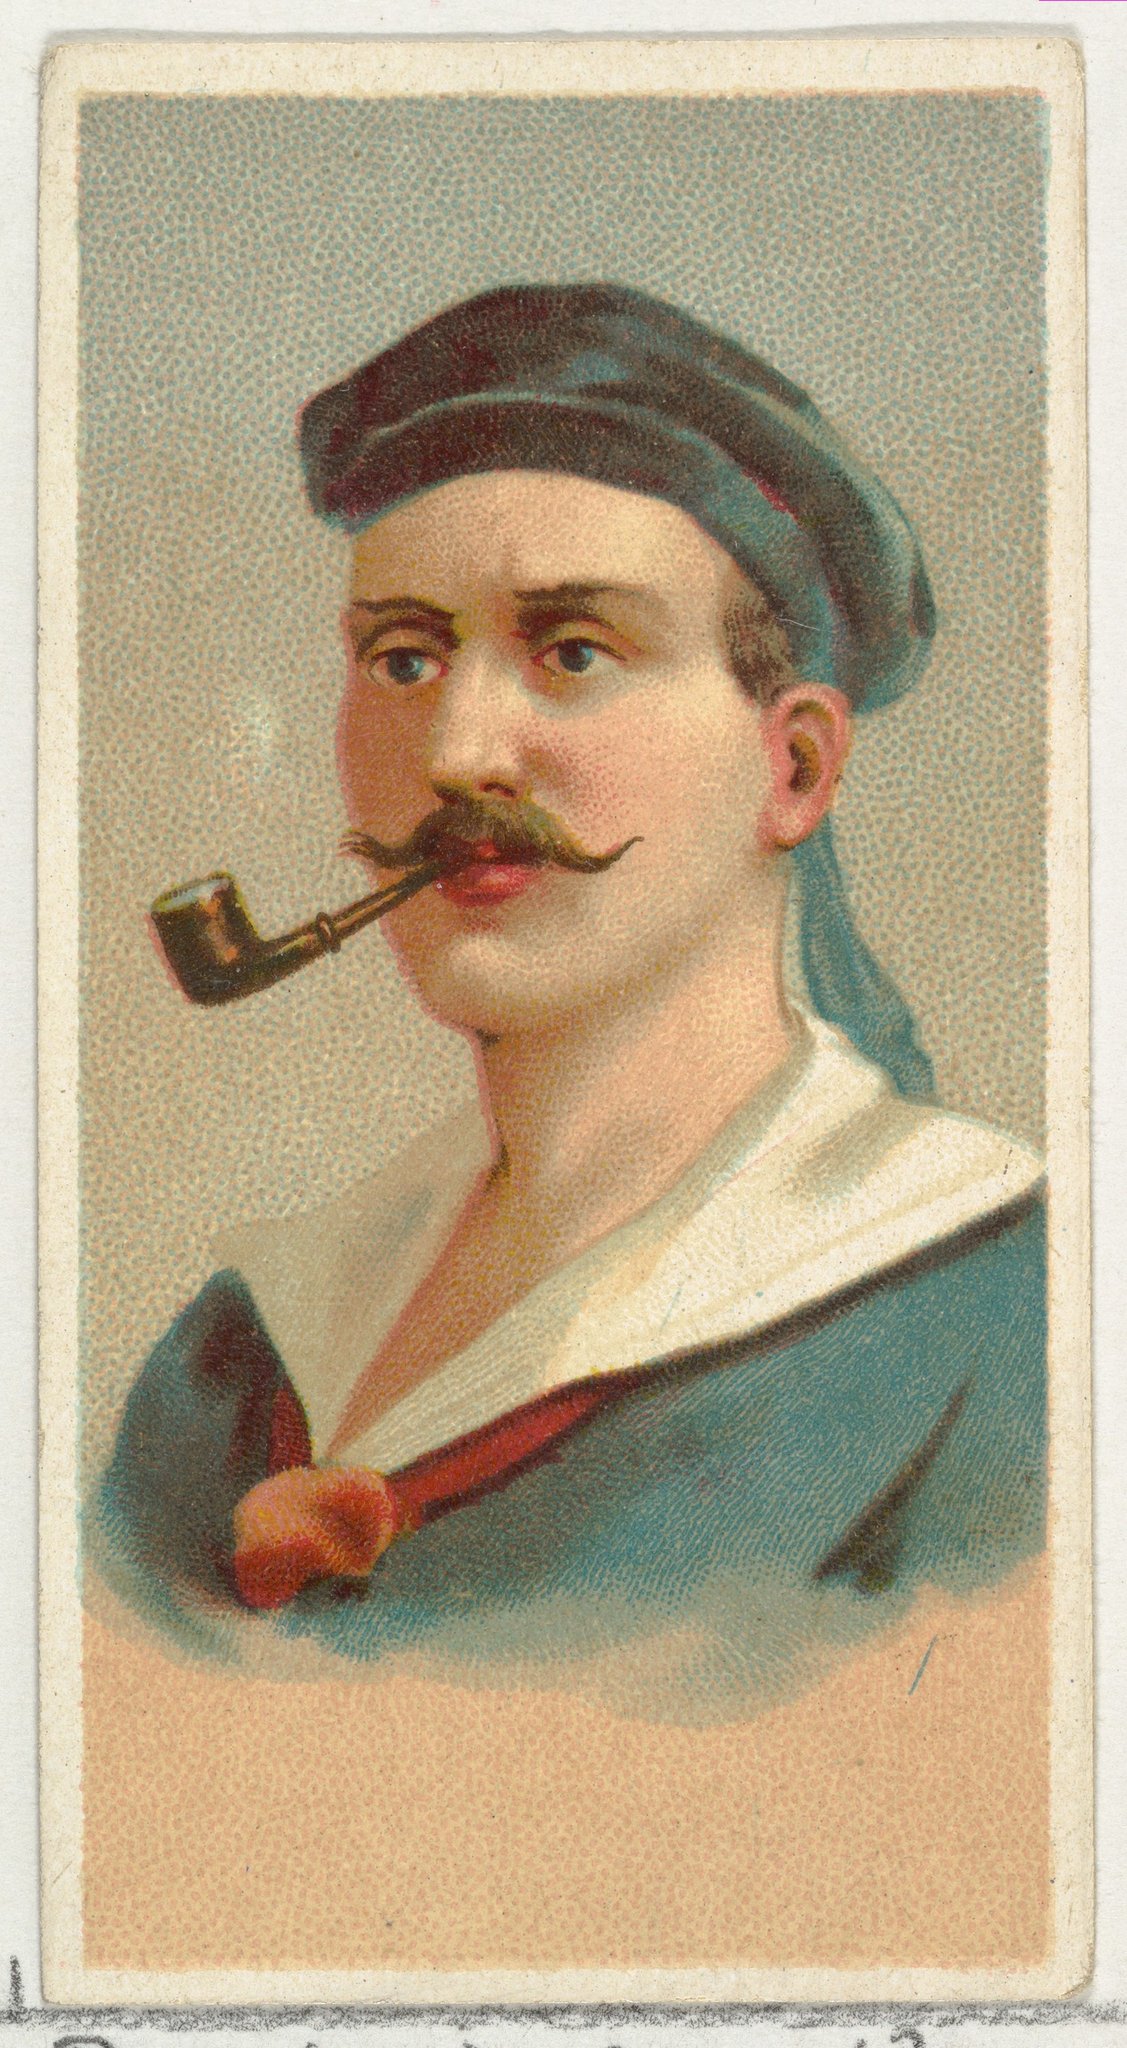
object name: print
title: Sailor, printer's sample from World's Smokers series (N33) for Allen & Ginter Cigarettes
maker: allen & ginter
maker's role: publisher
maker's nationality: american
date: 1888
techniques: color lithograph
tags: men,smoking